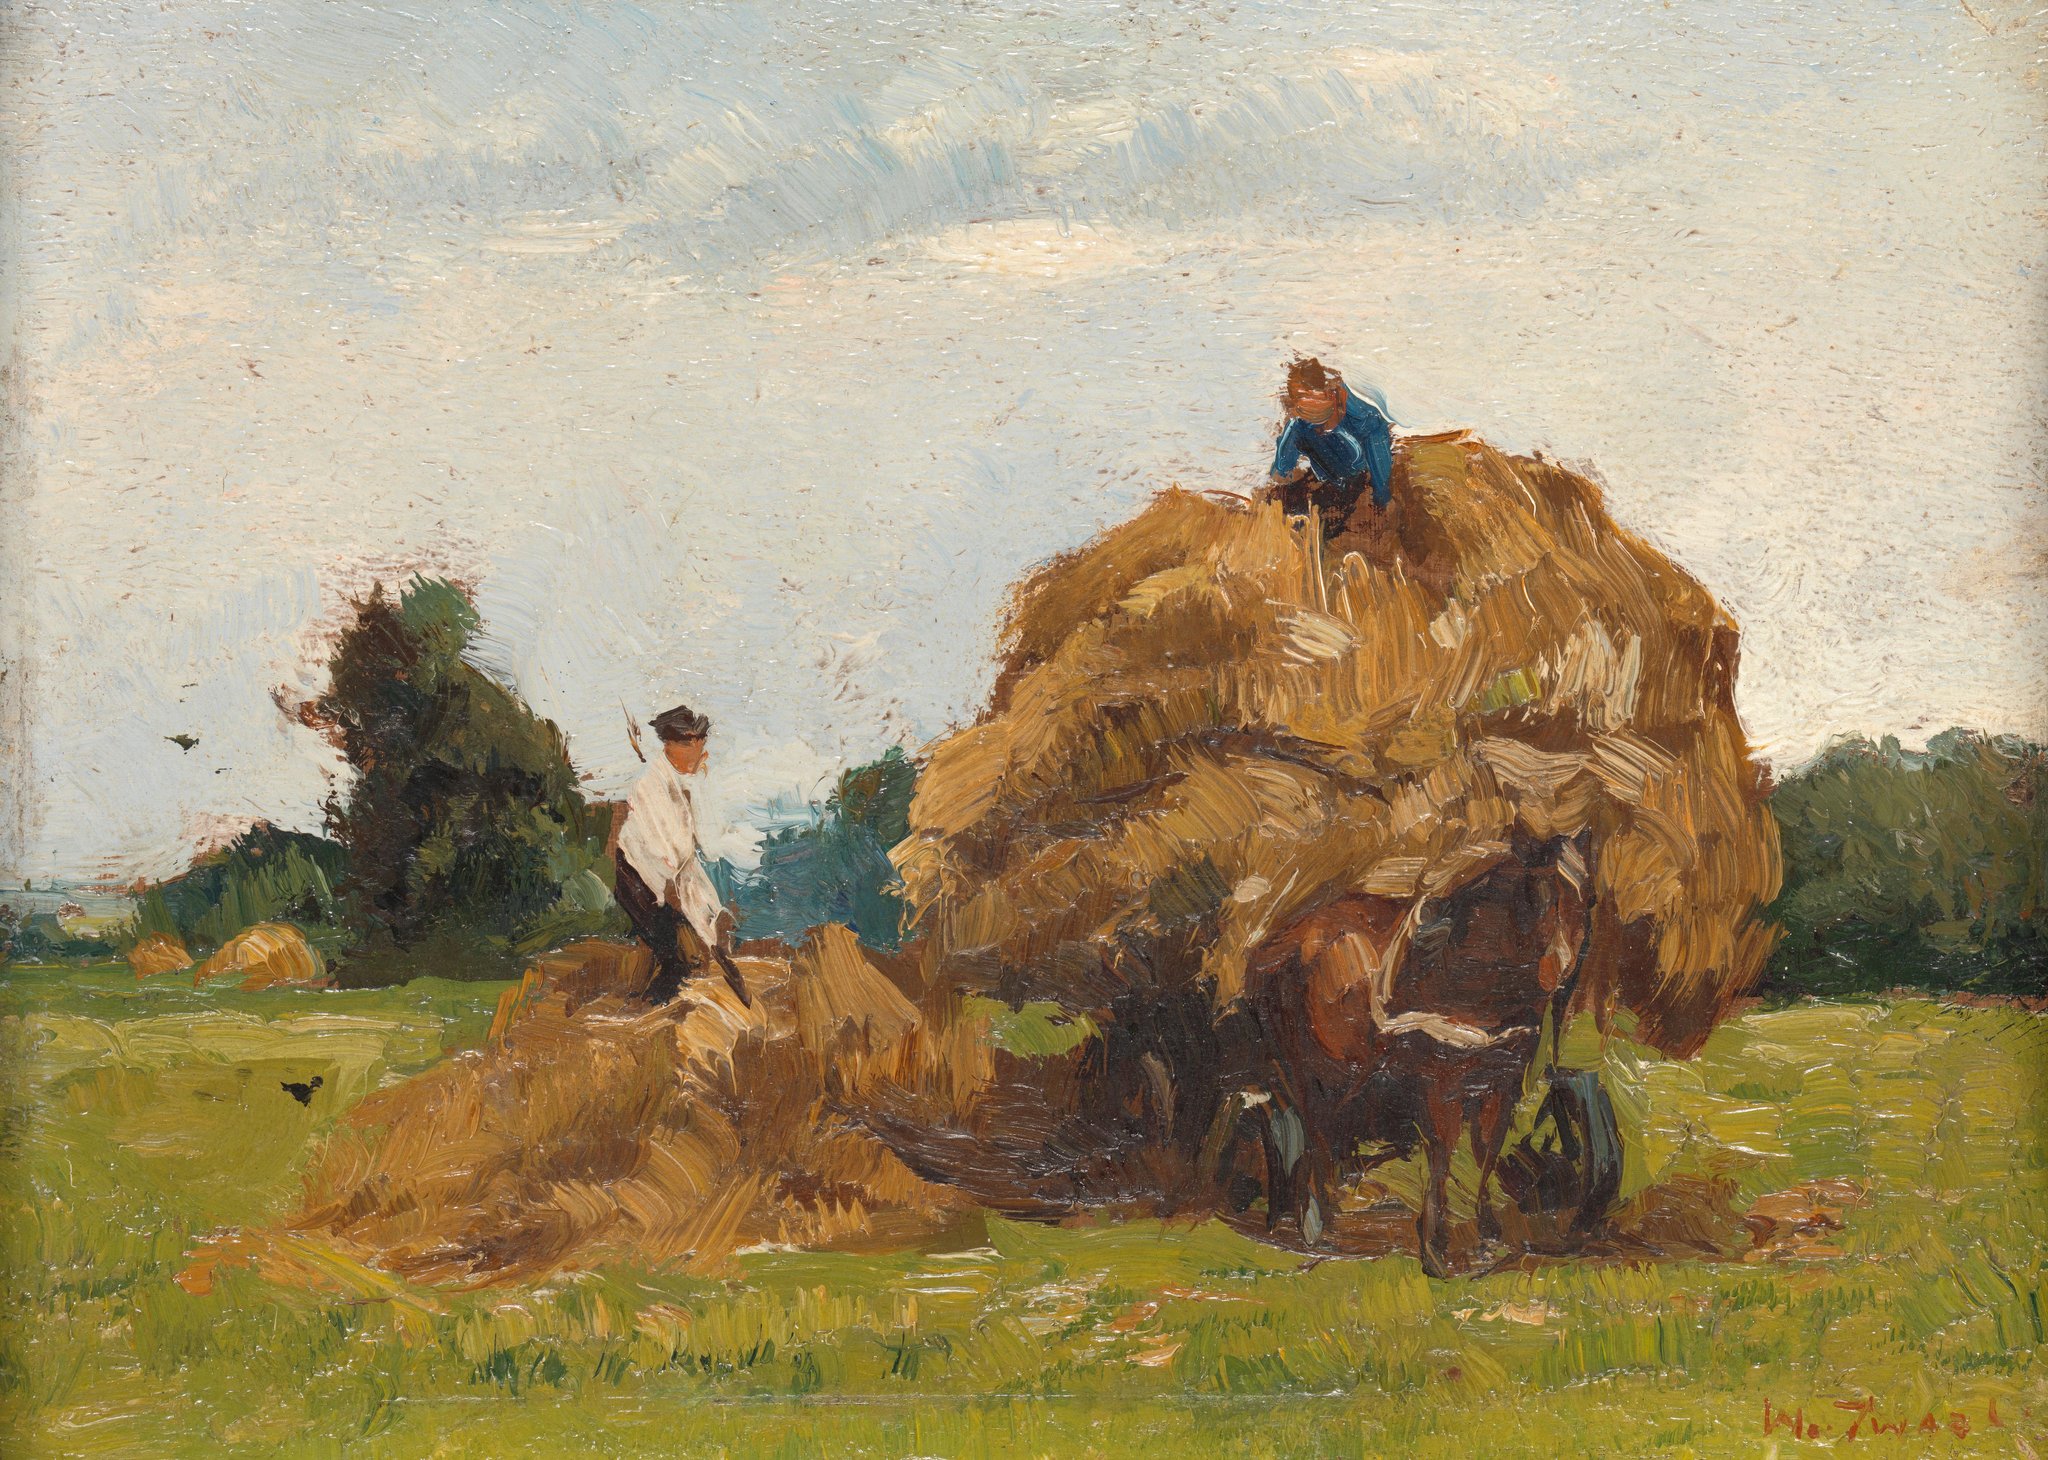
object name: painting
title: Hay Wagon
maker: willem de zwart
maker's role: draughtsman, painter, print maker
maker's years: 1862-1931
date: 1885-1931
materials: oil, panel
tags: hay-wagon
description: Twee boeren stapelen hooi op een hooiwagen met paard op het veld.